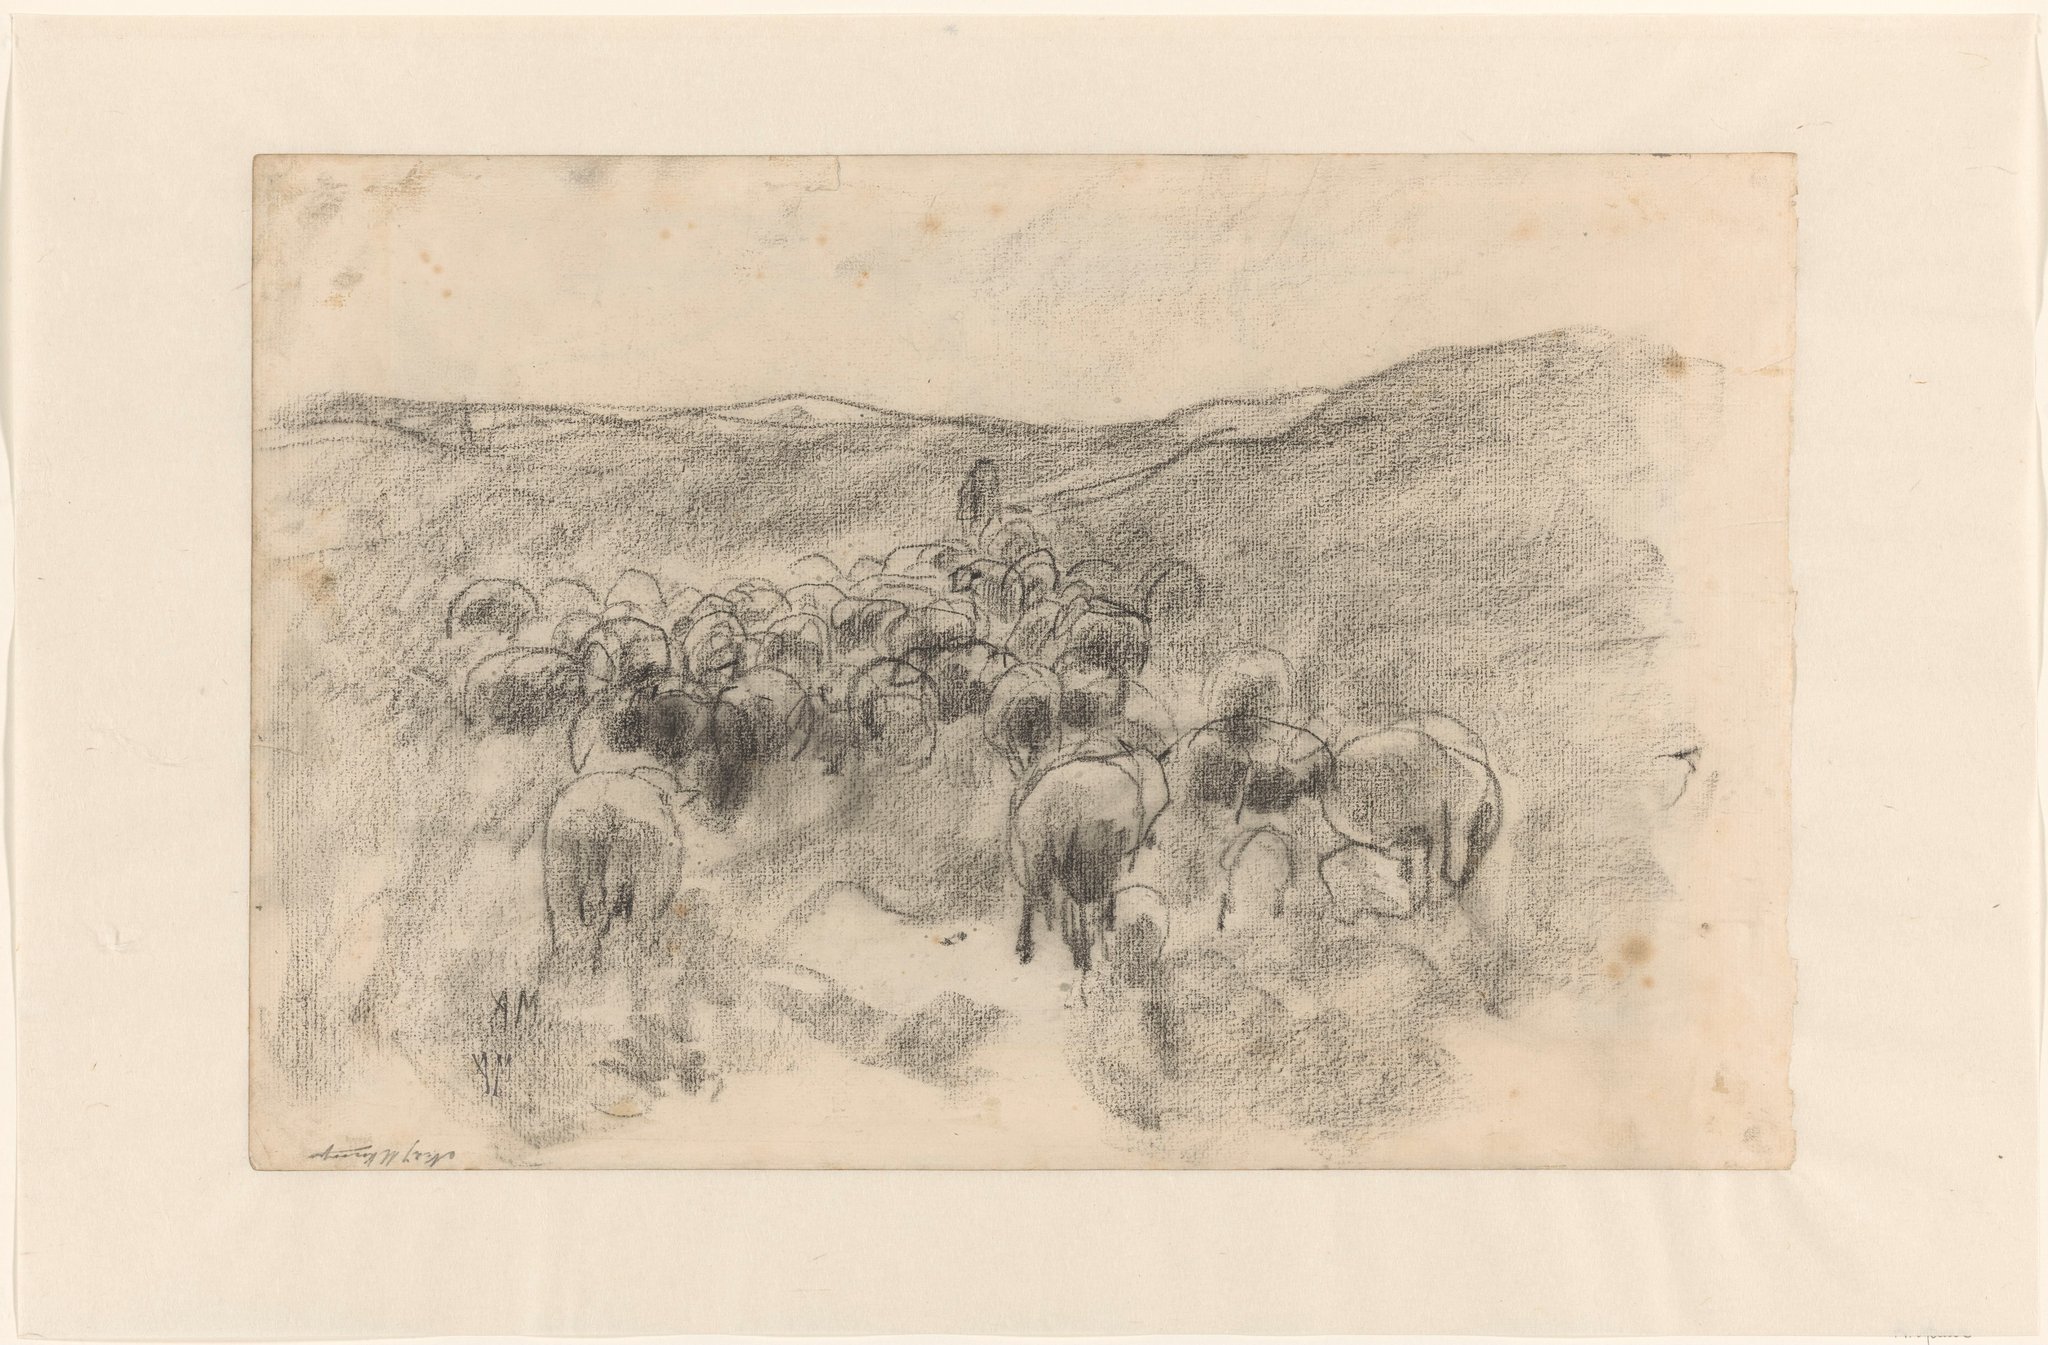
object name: drawing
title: Herder met kudde schapen op de heide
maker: anton mauve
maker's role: draughtsman, painter, print maker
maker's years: 1838-1888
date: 1848-1888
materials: chalk, paper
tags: sheep, herd, flock